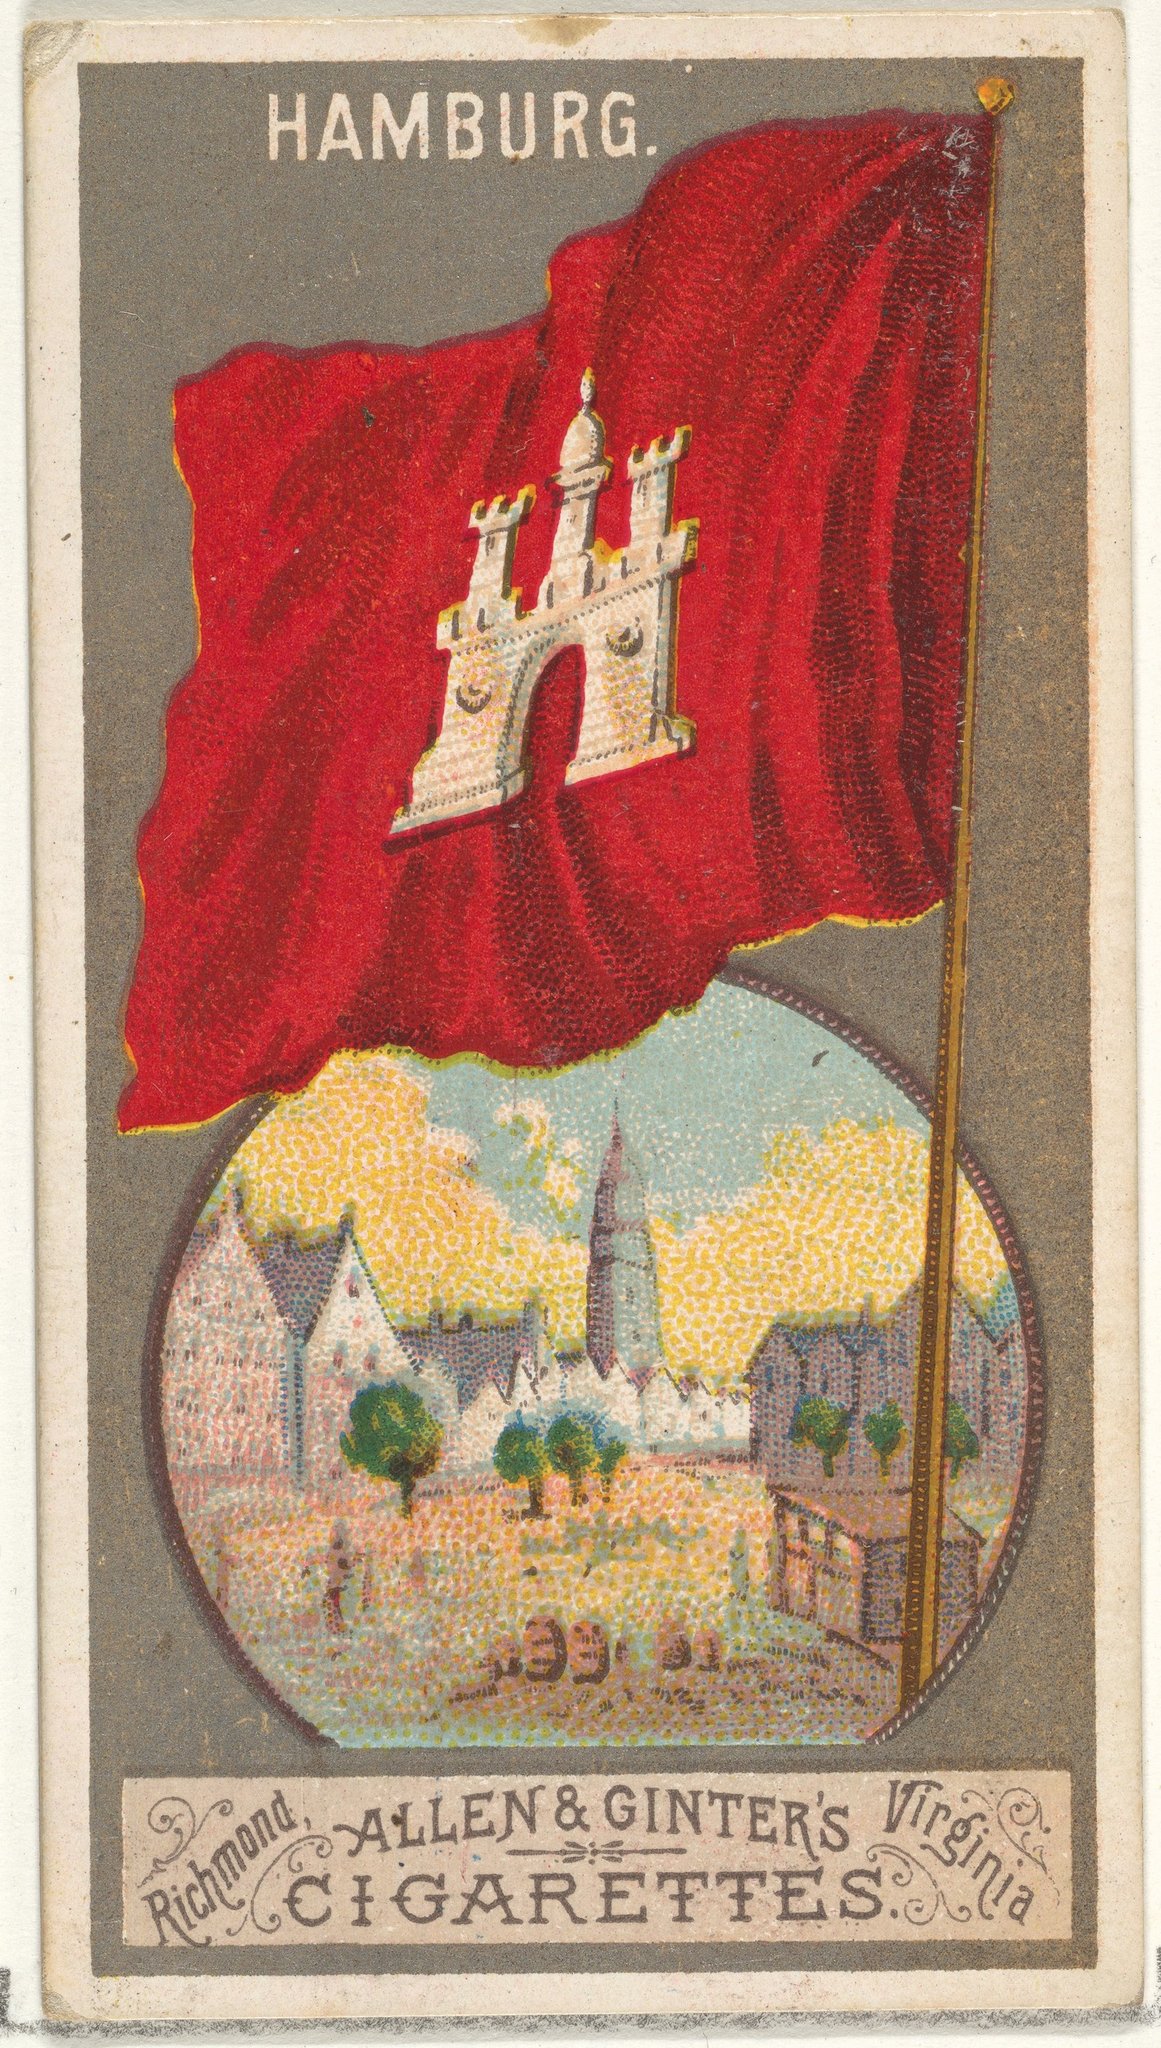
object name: print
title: Hamburg, from the City Flags series (N6) for Allen & Ginter Cigarettes Brands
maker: allen & ginter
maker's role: publisher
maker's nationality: american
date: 1887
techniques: color lithograph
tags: coat of arms,flags